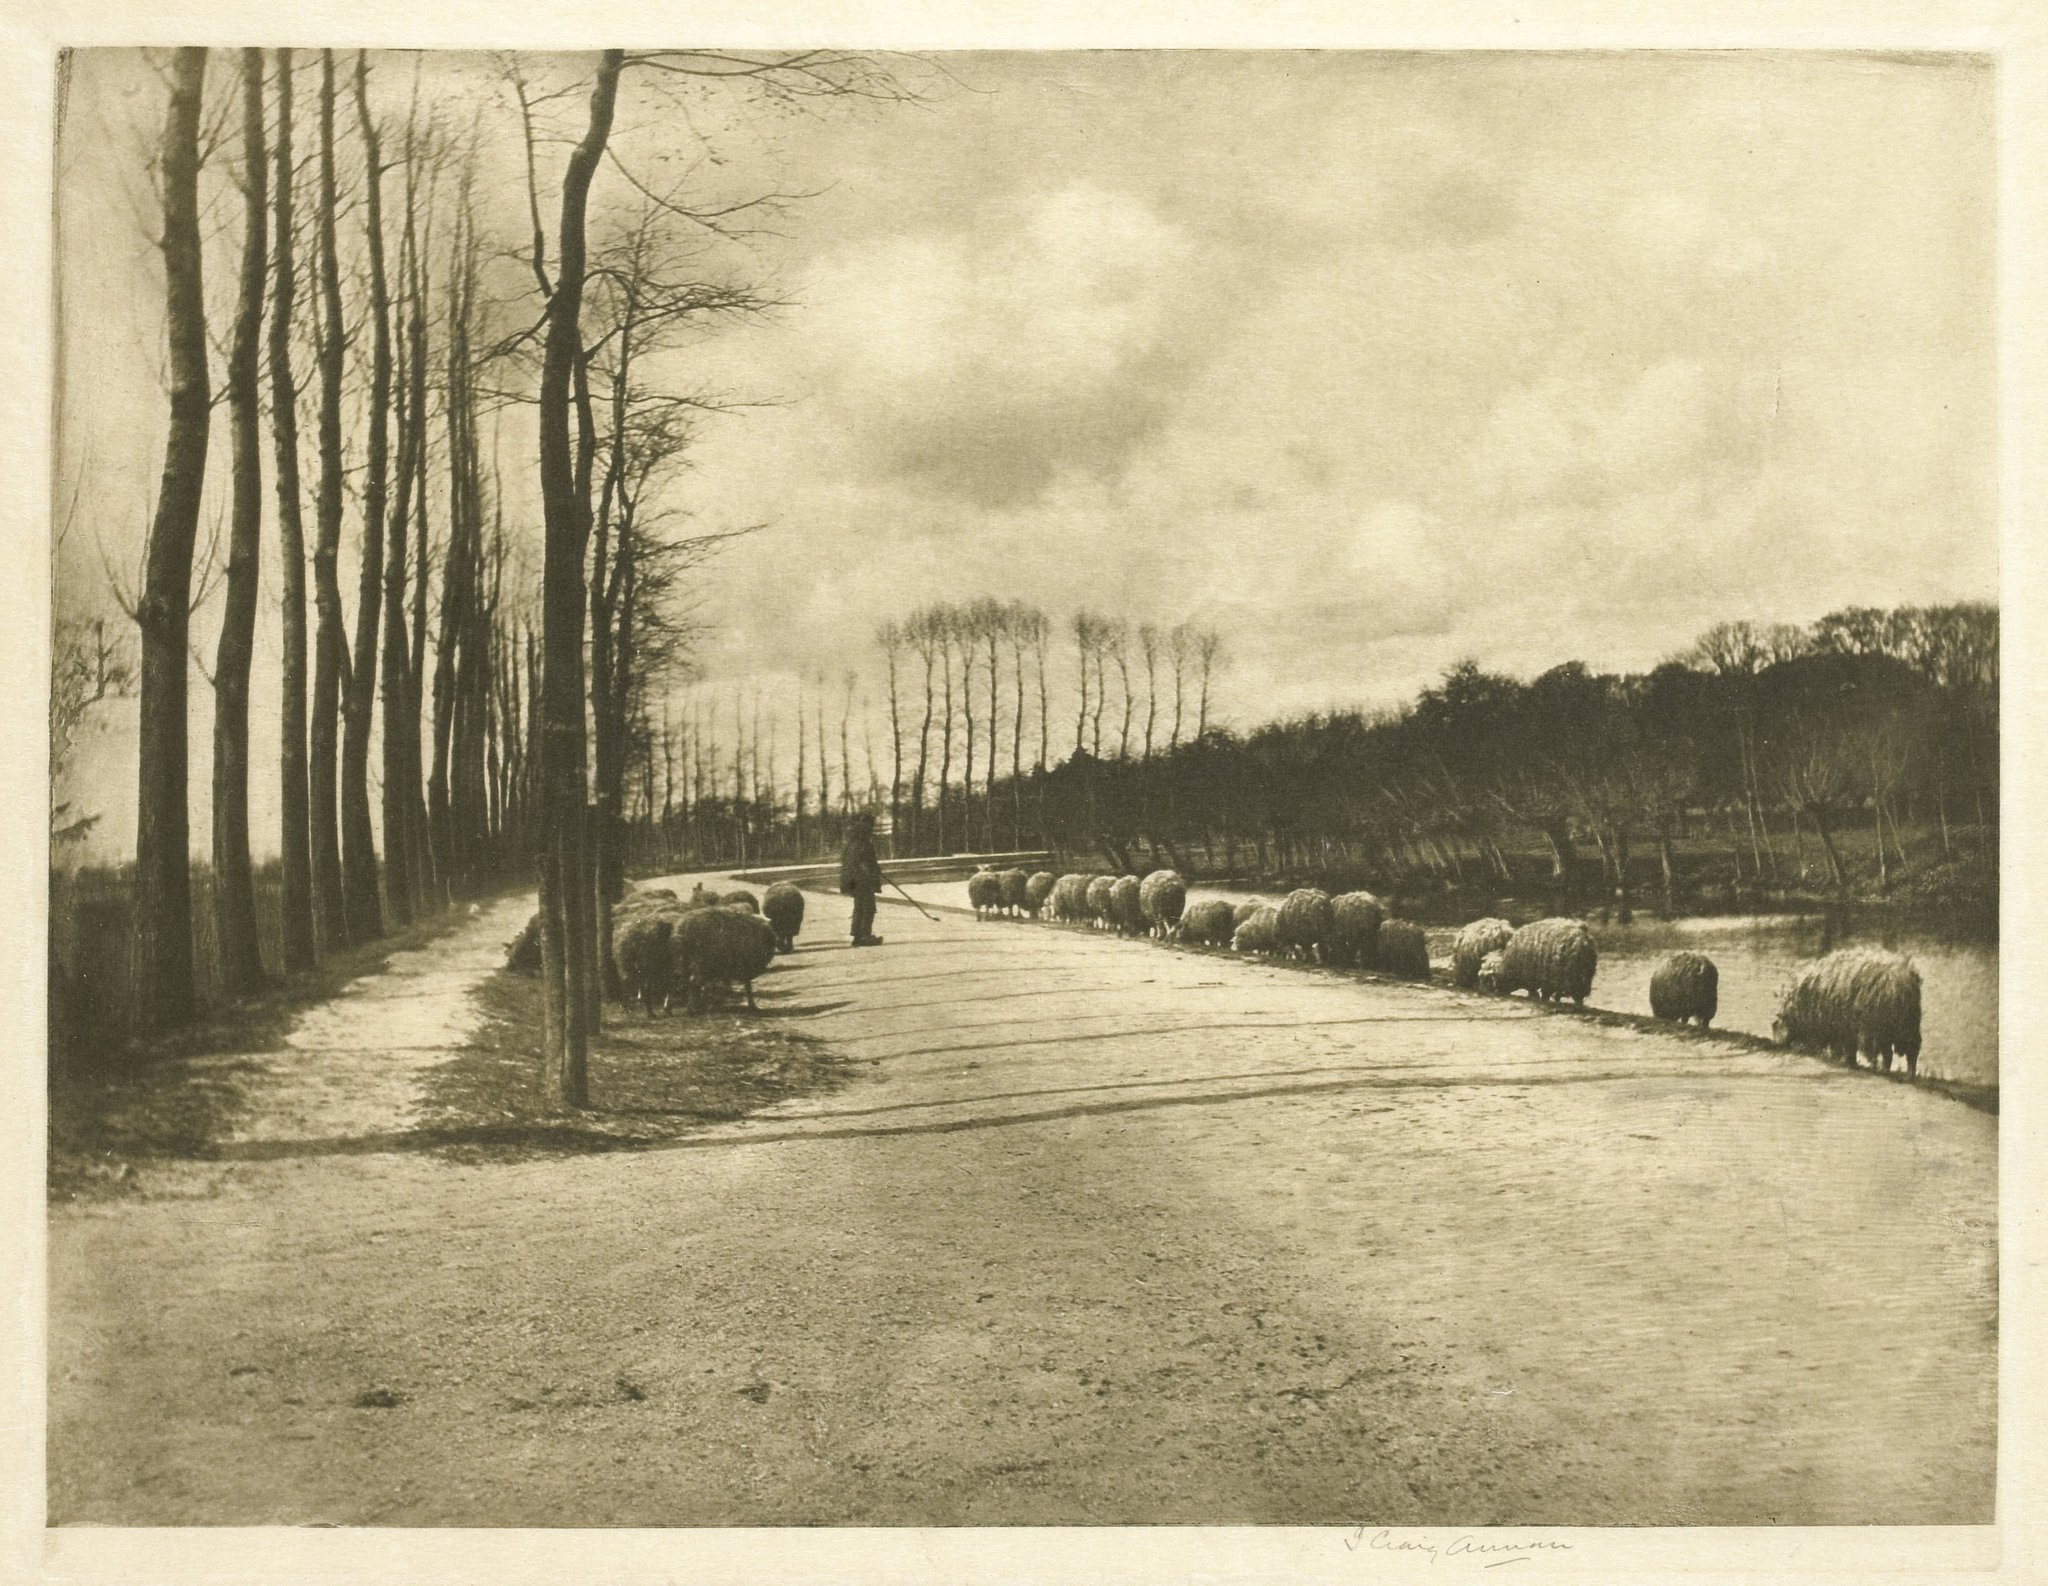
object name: photomechanical print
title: A Utrecht Pastorale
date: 1892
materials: paper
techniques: photoaquatint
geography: utrecht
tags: herding, herdsman, herdswoman, shepherd, shepherdess, cowherd, etc., herd, flock, utrecht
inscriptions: number: ‘77298’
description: At first sight this rustic scene looks more like a painting than a photograph. In his native Glasgow, Annan saw an exhibition of the Dutch Hague School painters and was captivated by their work. He toured through the Netherlands recording the land, water, coast and grey skies, and the uniform light.